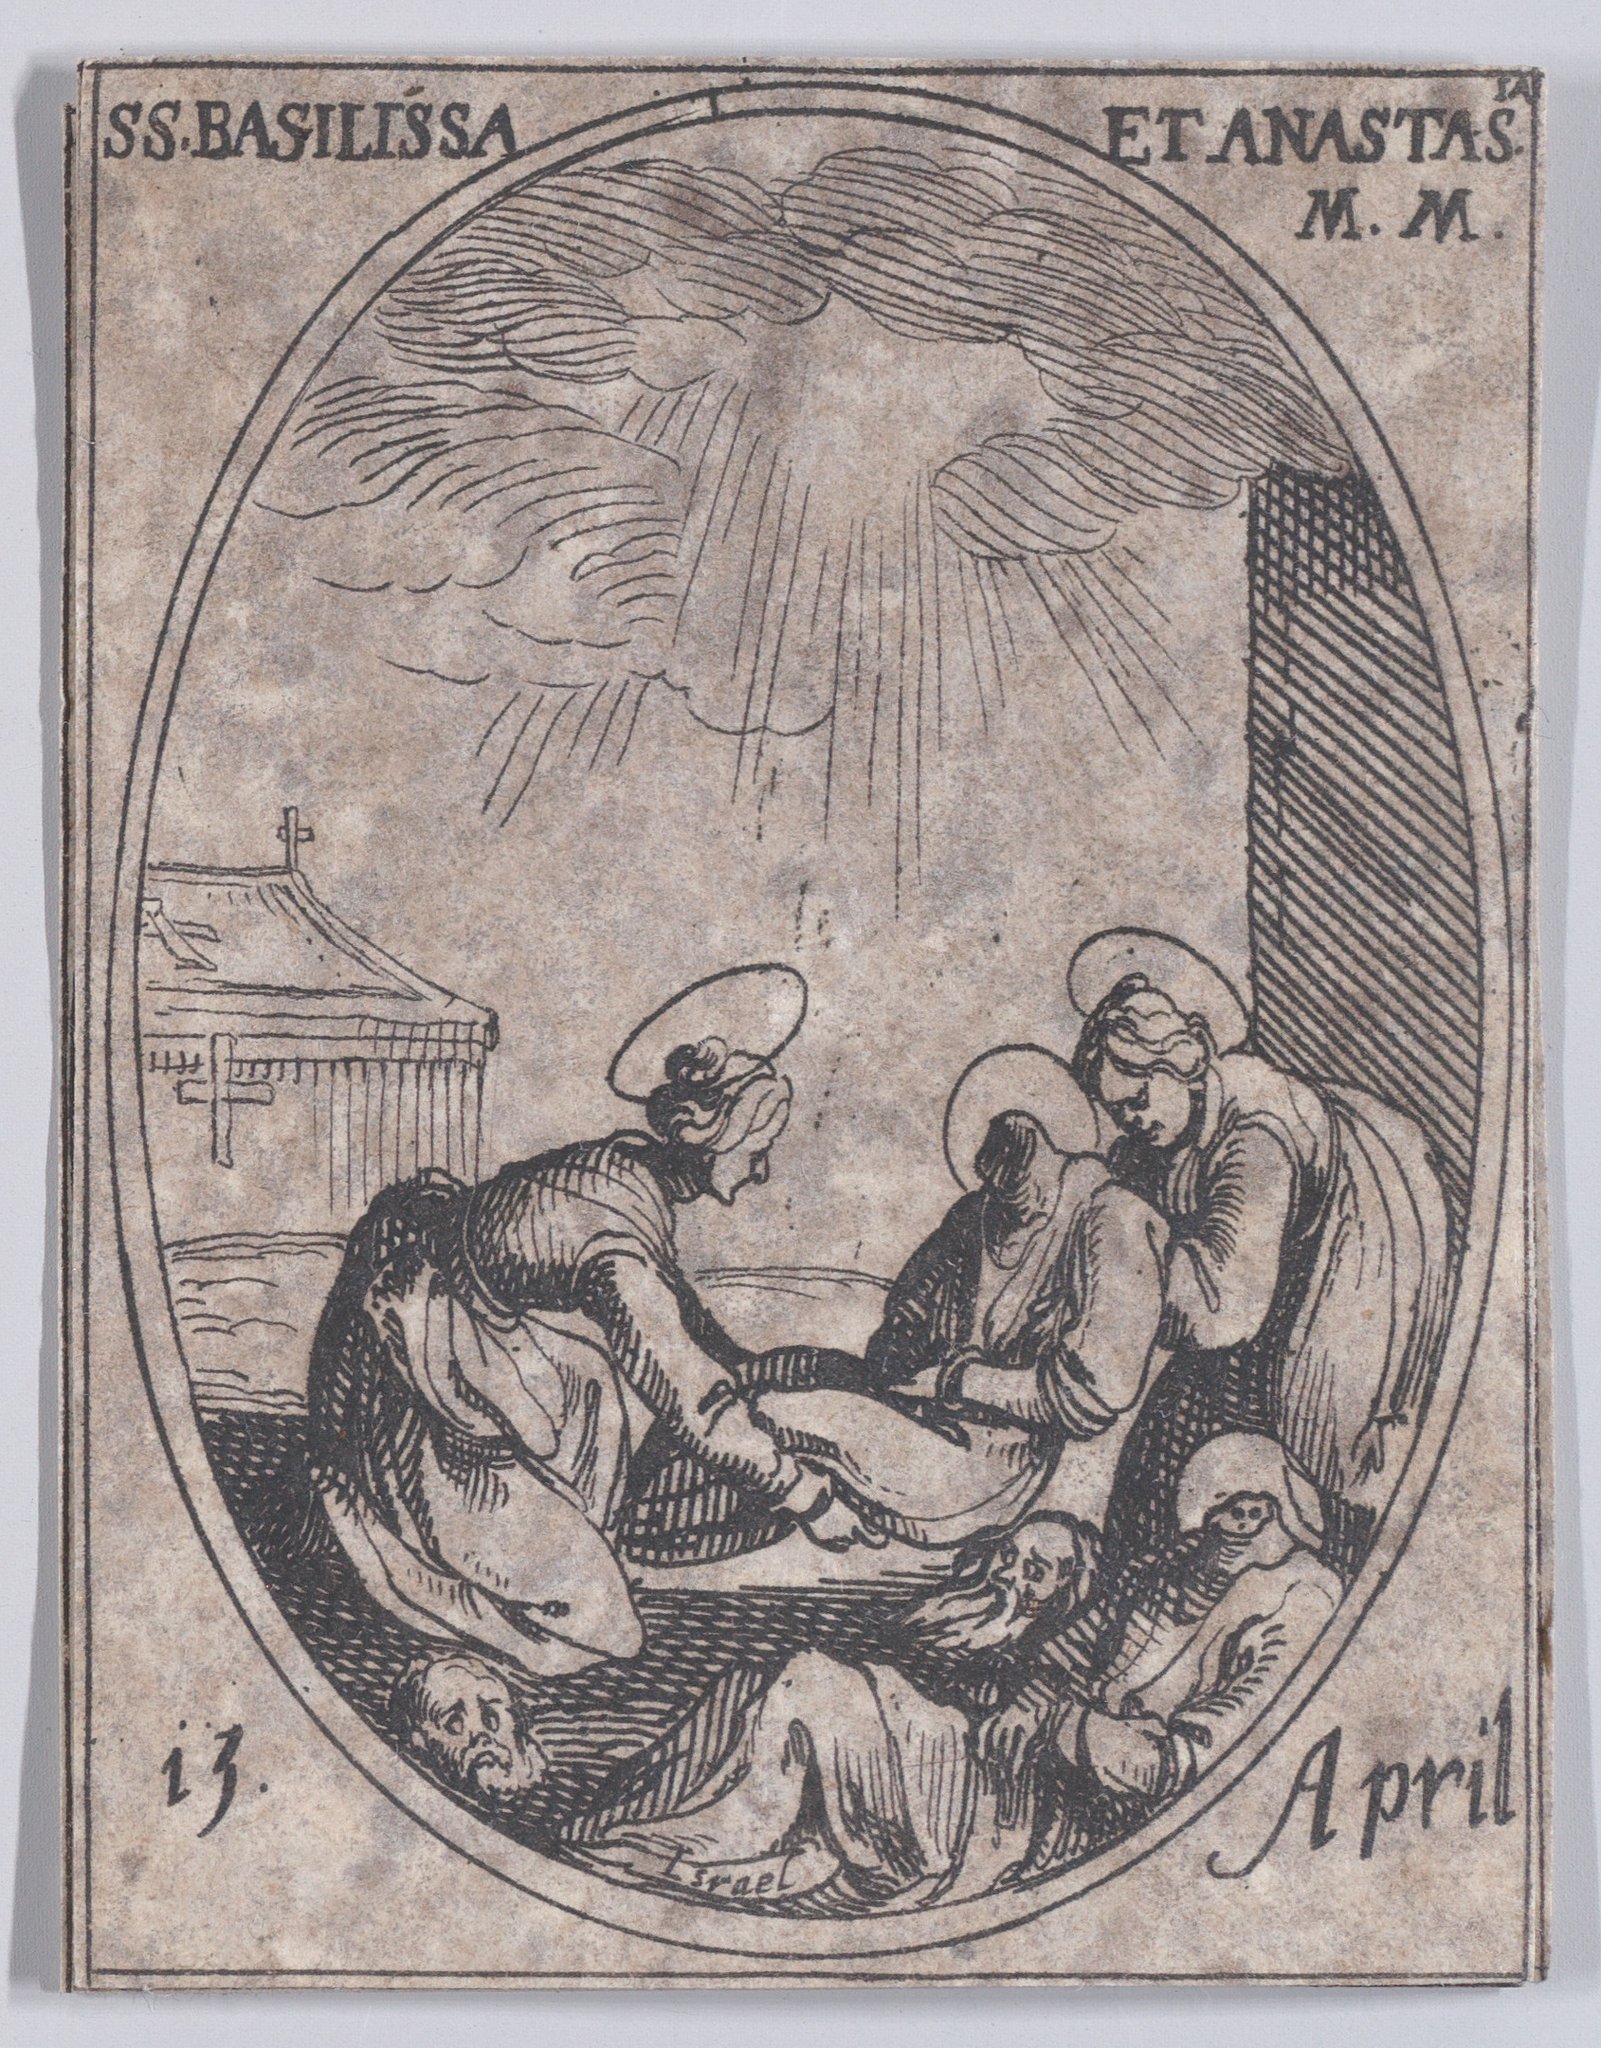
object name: print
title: Ste. Basilisse et Ste. Anastasie (St. Basilissa and St. Anastasia), April 15th, from "Les Images De Tous Les Saincts et Saintes de L'Année" (Images of All of the Saints and Religious Events of the Year)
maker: jacques callot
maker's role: artist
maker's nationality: french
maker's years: 1592-1635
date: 1636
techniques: etching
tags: men,women,saints